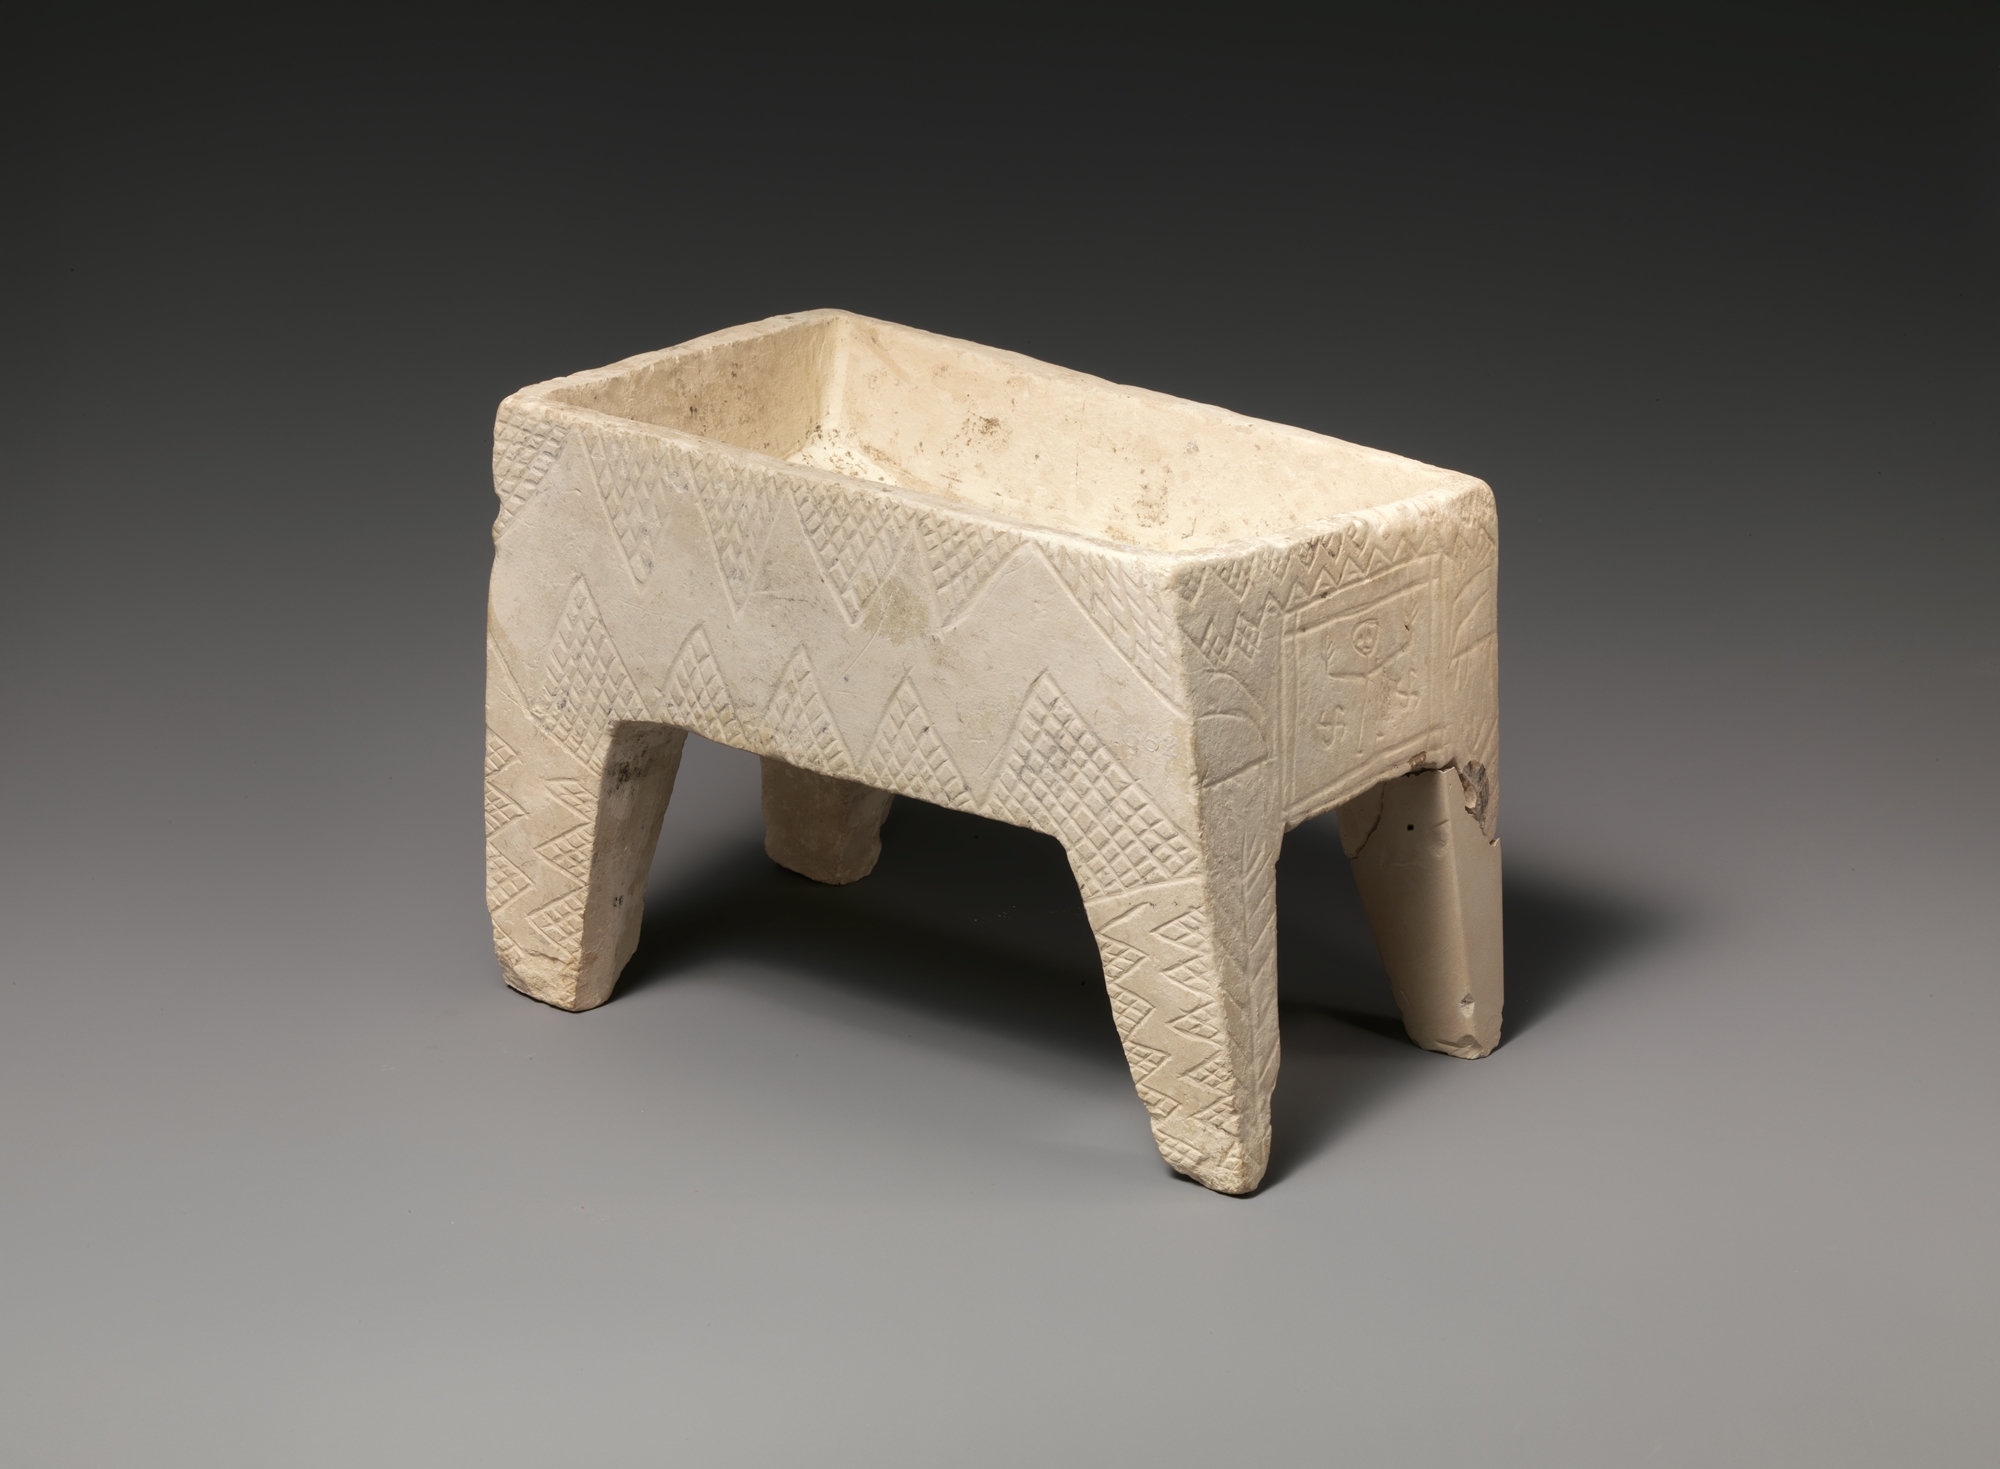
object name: model of a coffin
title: Limestone model of a coffin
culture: cypriot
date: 1050-950 BCE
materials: limestone